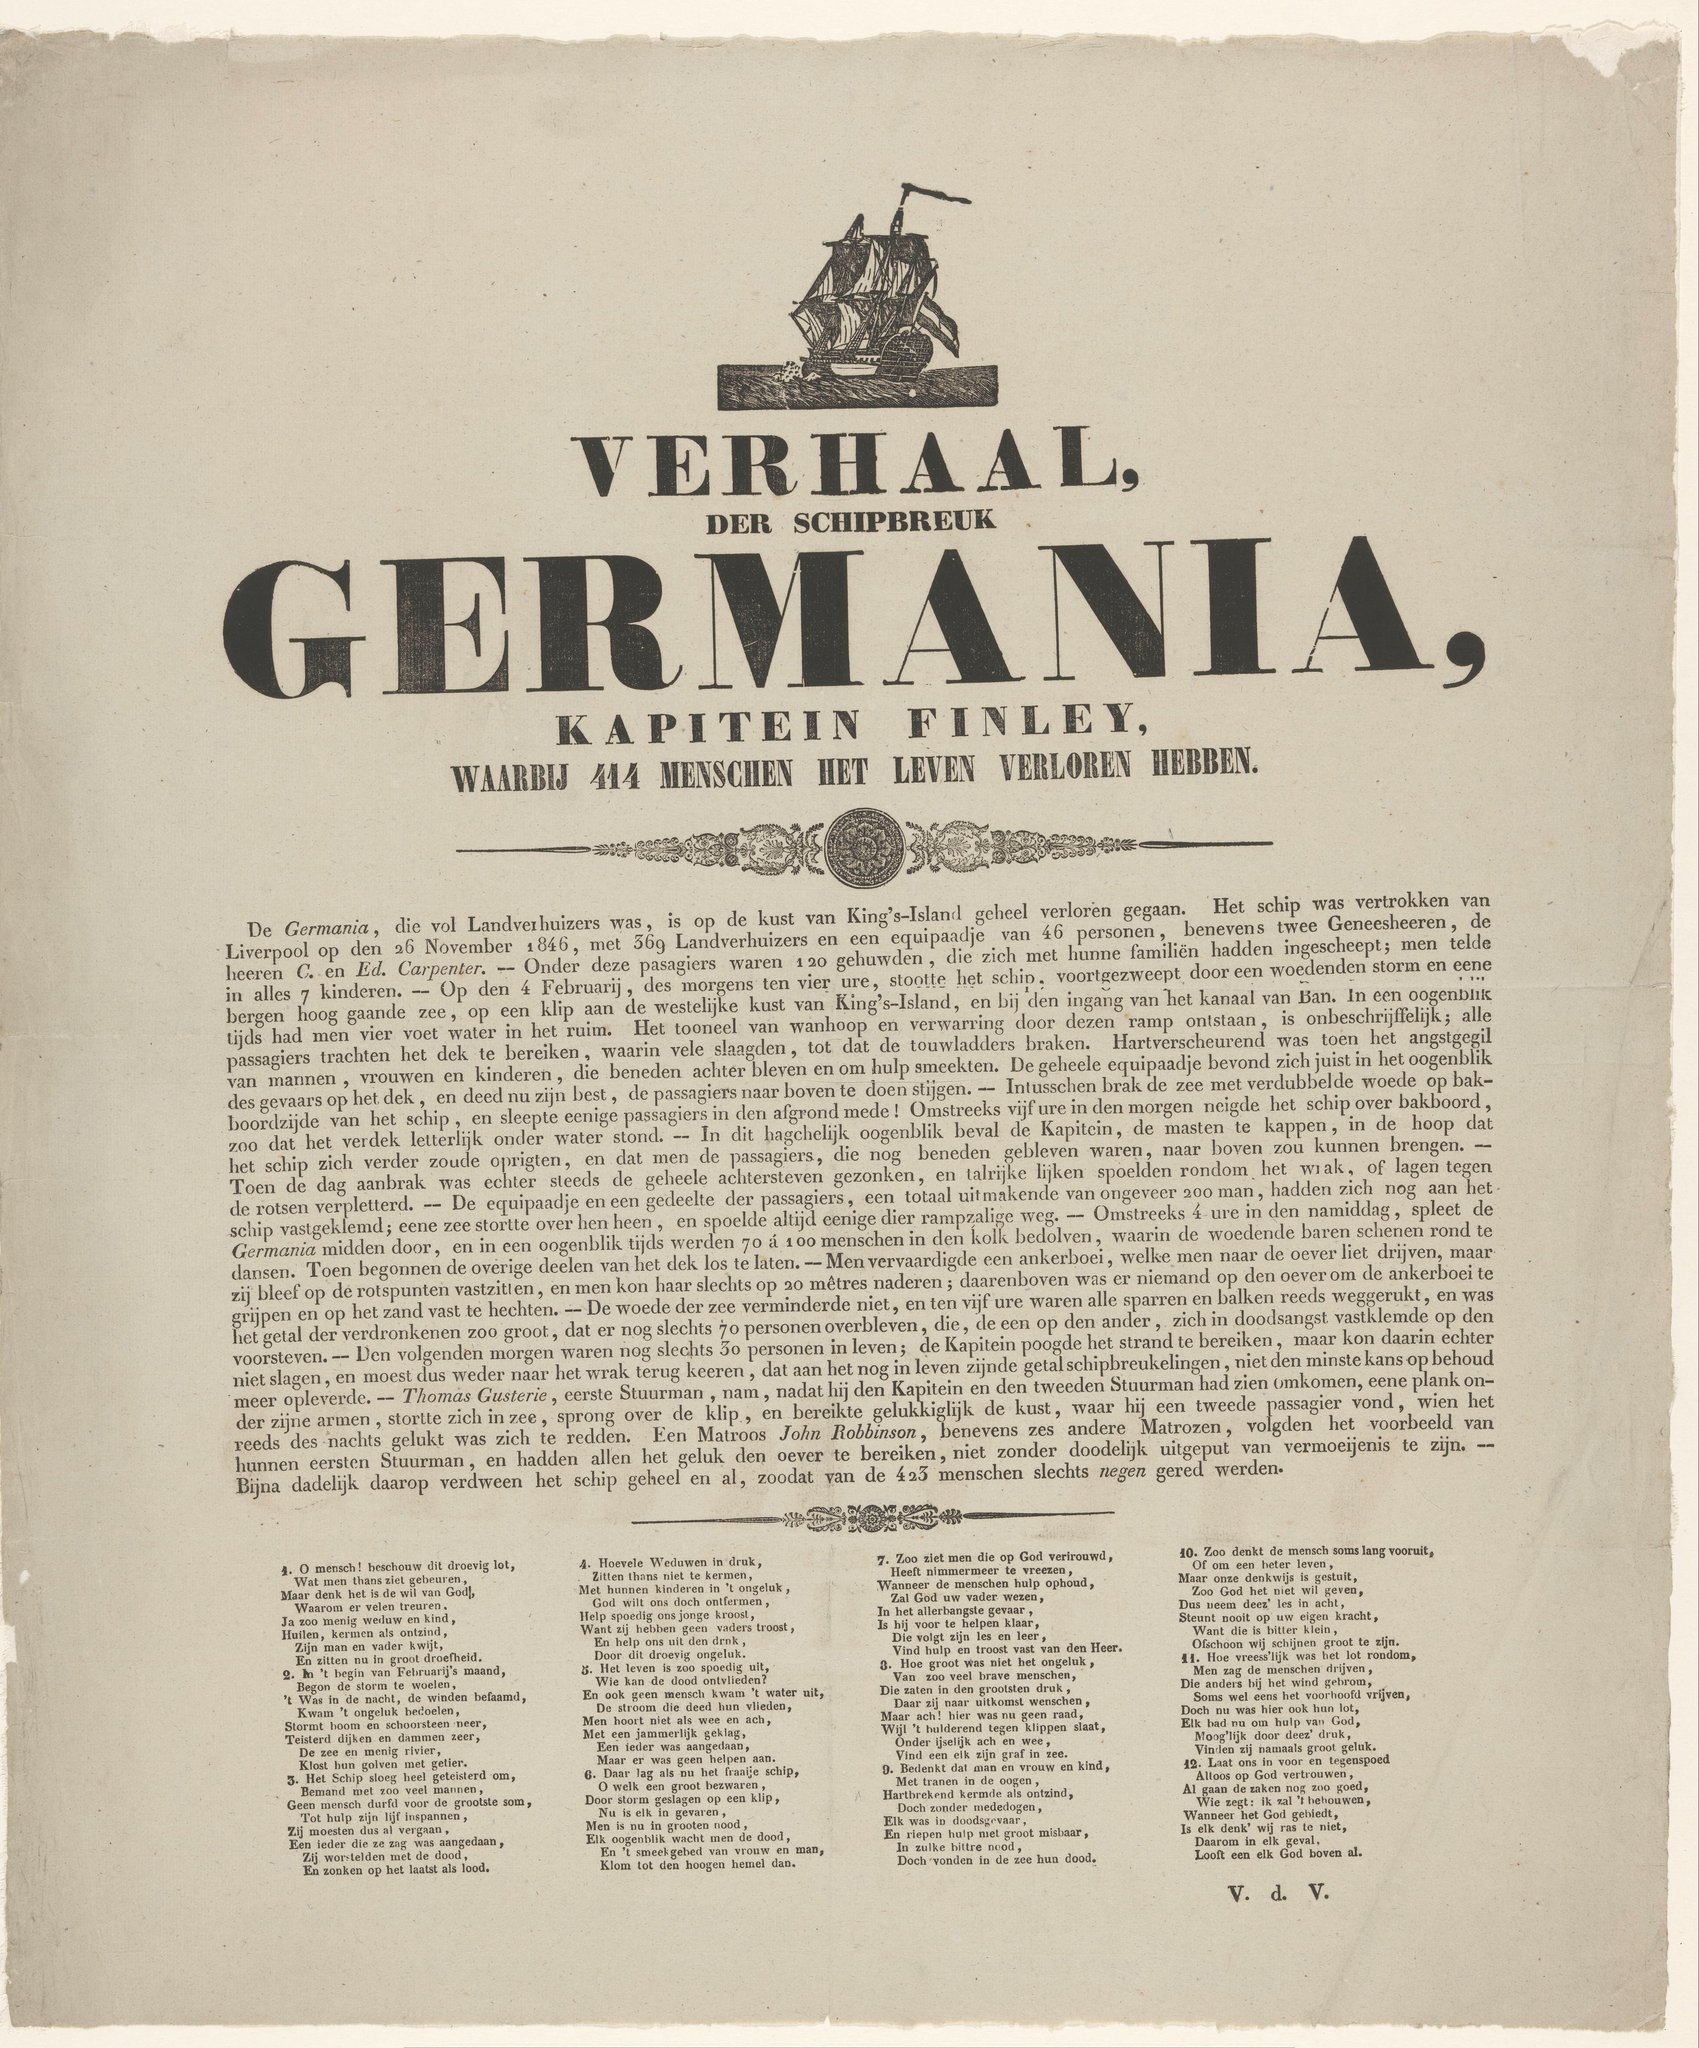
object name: print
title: Schipbreuk van de Germania, 4 februari 1847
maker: Anonymous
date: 1847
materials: paper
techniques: letterpress printing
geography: netherlands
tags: shipwreck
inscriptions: collector's mark: Lugt 2228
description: Blad met tekst over het vergaan van het schip 'Germania' met 369 landverhuizers op 4 februari 1847 voor de kust van Kings Island. Gedrukte tekst met bovenaan een vignet van een zeilschip. Onder het verhaal een vers in vier kolommen. Onder de tekst de letters: V. d. V.